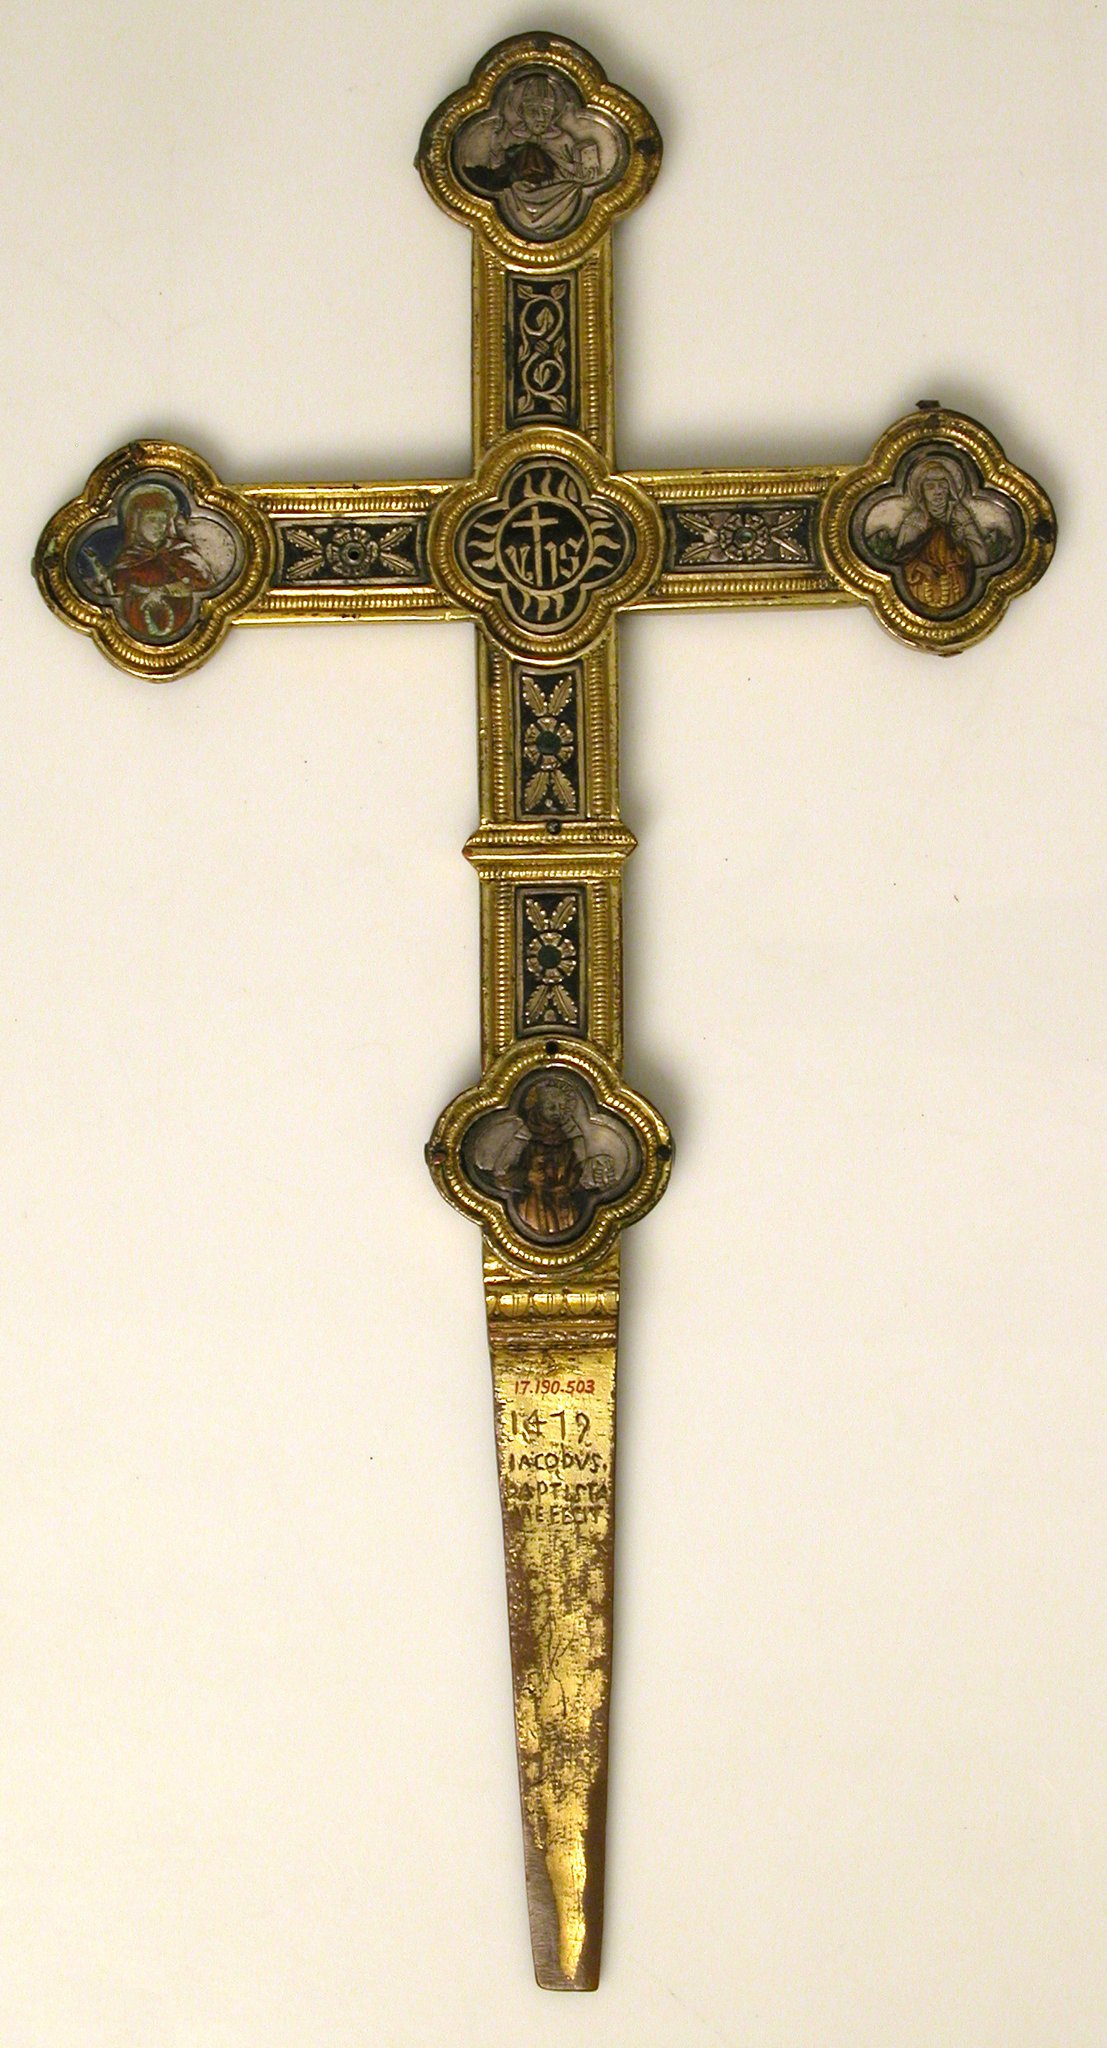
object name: altar cross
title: Processional Cross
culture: italian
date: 1479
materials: gilt copper, enamel, niello, silver, silver gilt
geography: italy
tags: saint catherine,saint francis,insignia